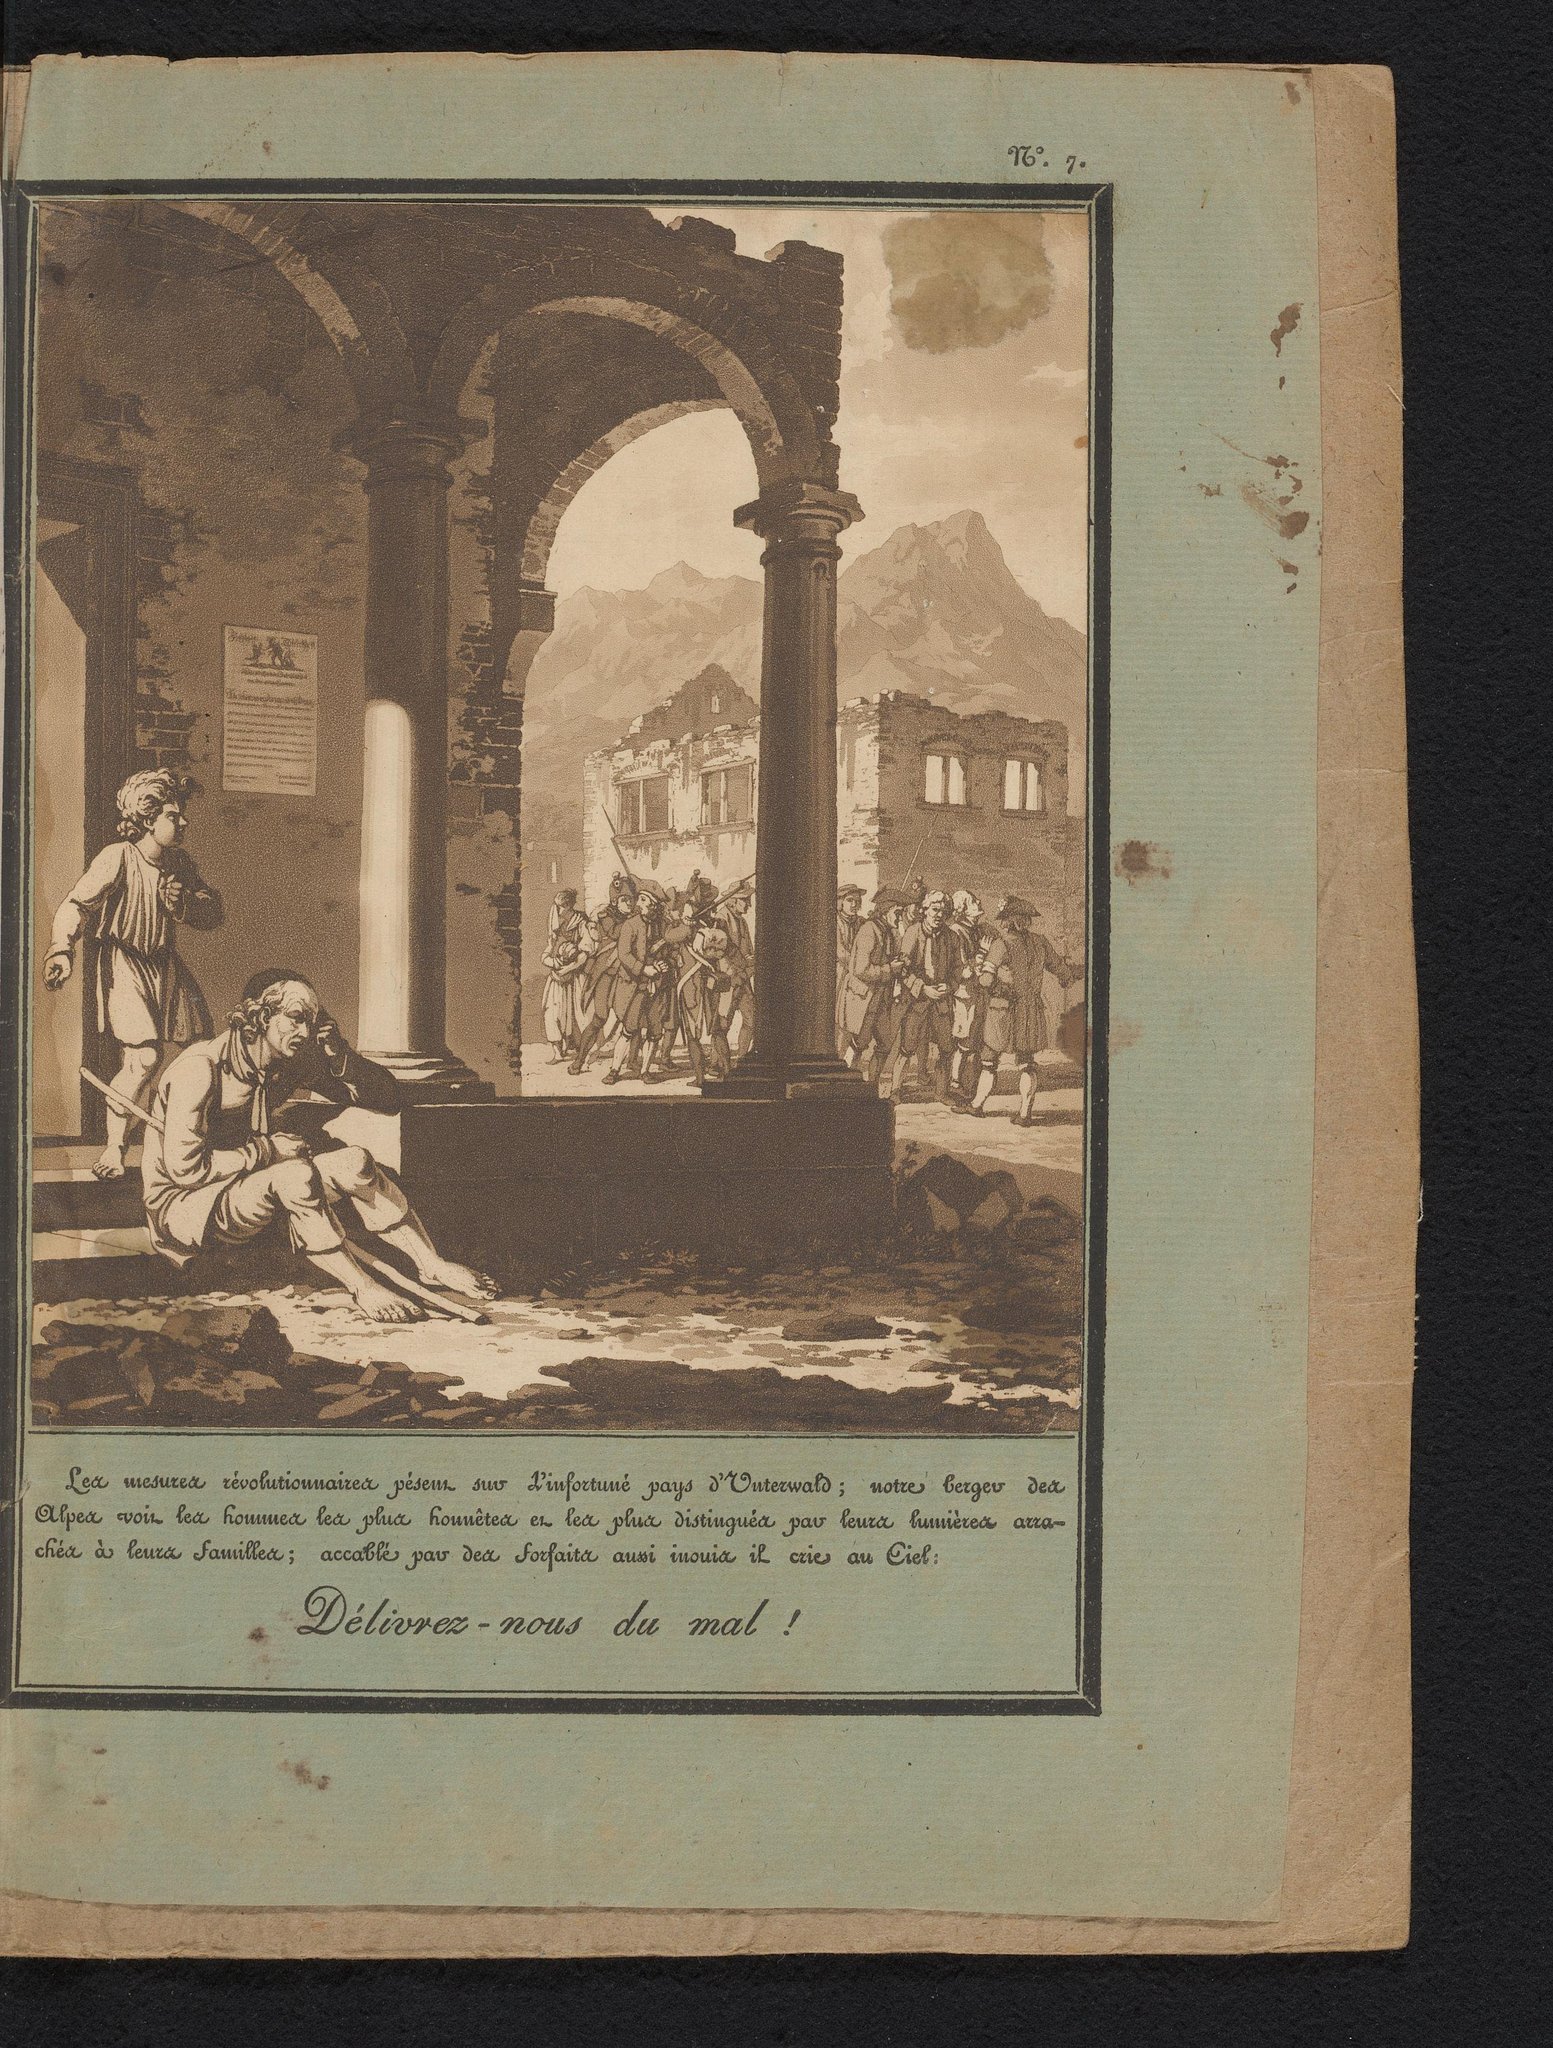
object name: album leaf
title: Paternoster voor de inwoners van Unterwalden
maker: marquard wocher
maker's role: painter, print maker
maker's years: 1760-1830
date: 1803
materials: paper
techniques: aquatint, letterpress printing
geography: basel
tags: (private) prayer; 'oratione', 'preghiere', 'preghiere a dio' (ripa), hiding, hiding oneself, switzerland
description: Tekst in het Frans en nummering op het albumblad. Prent maakt deel uit van een album.